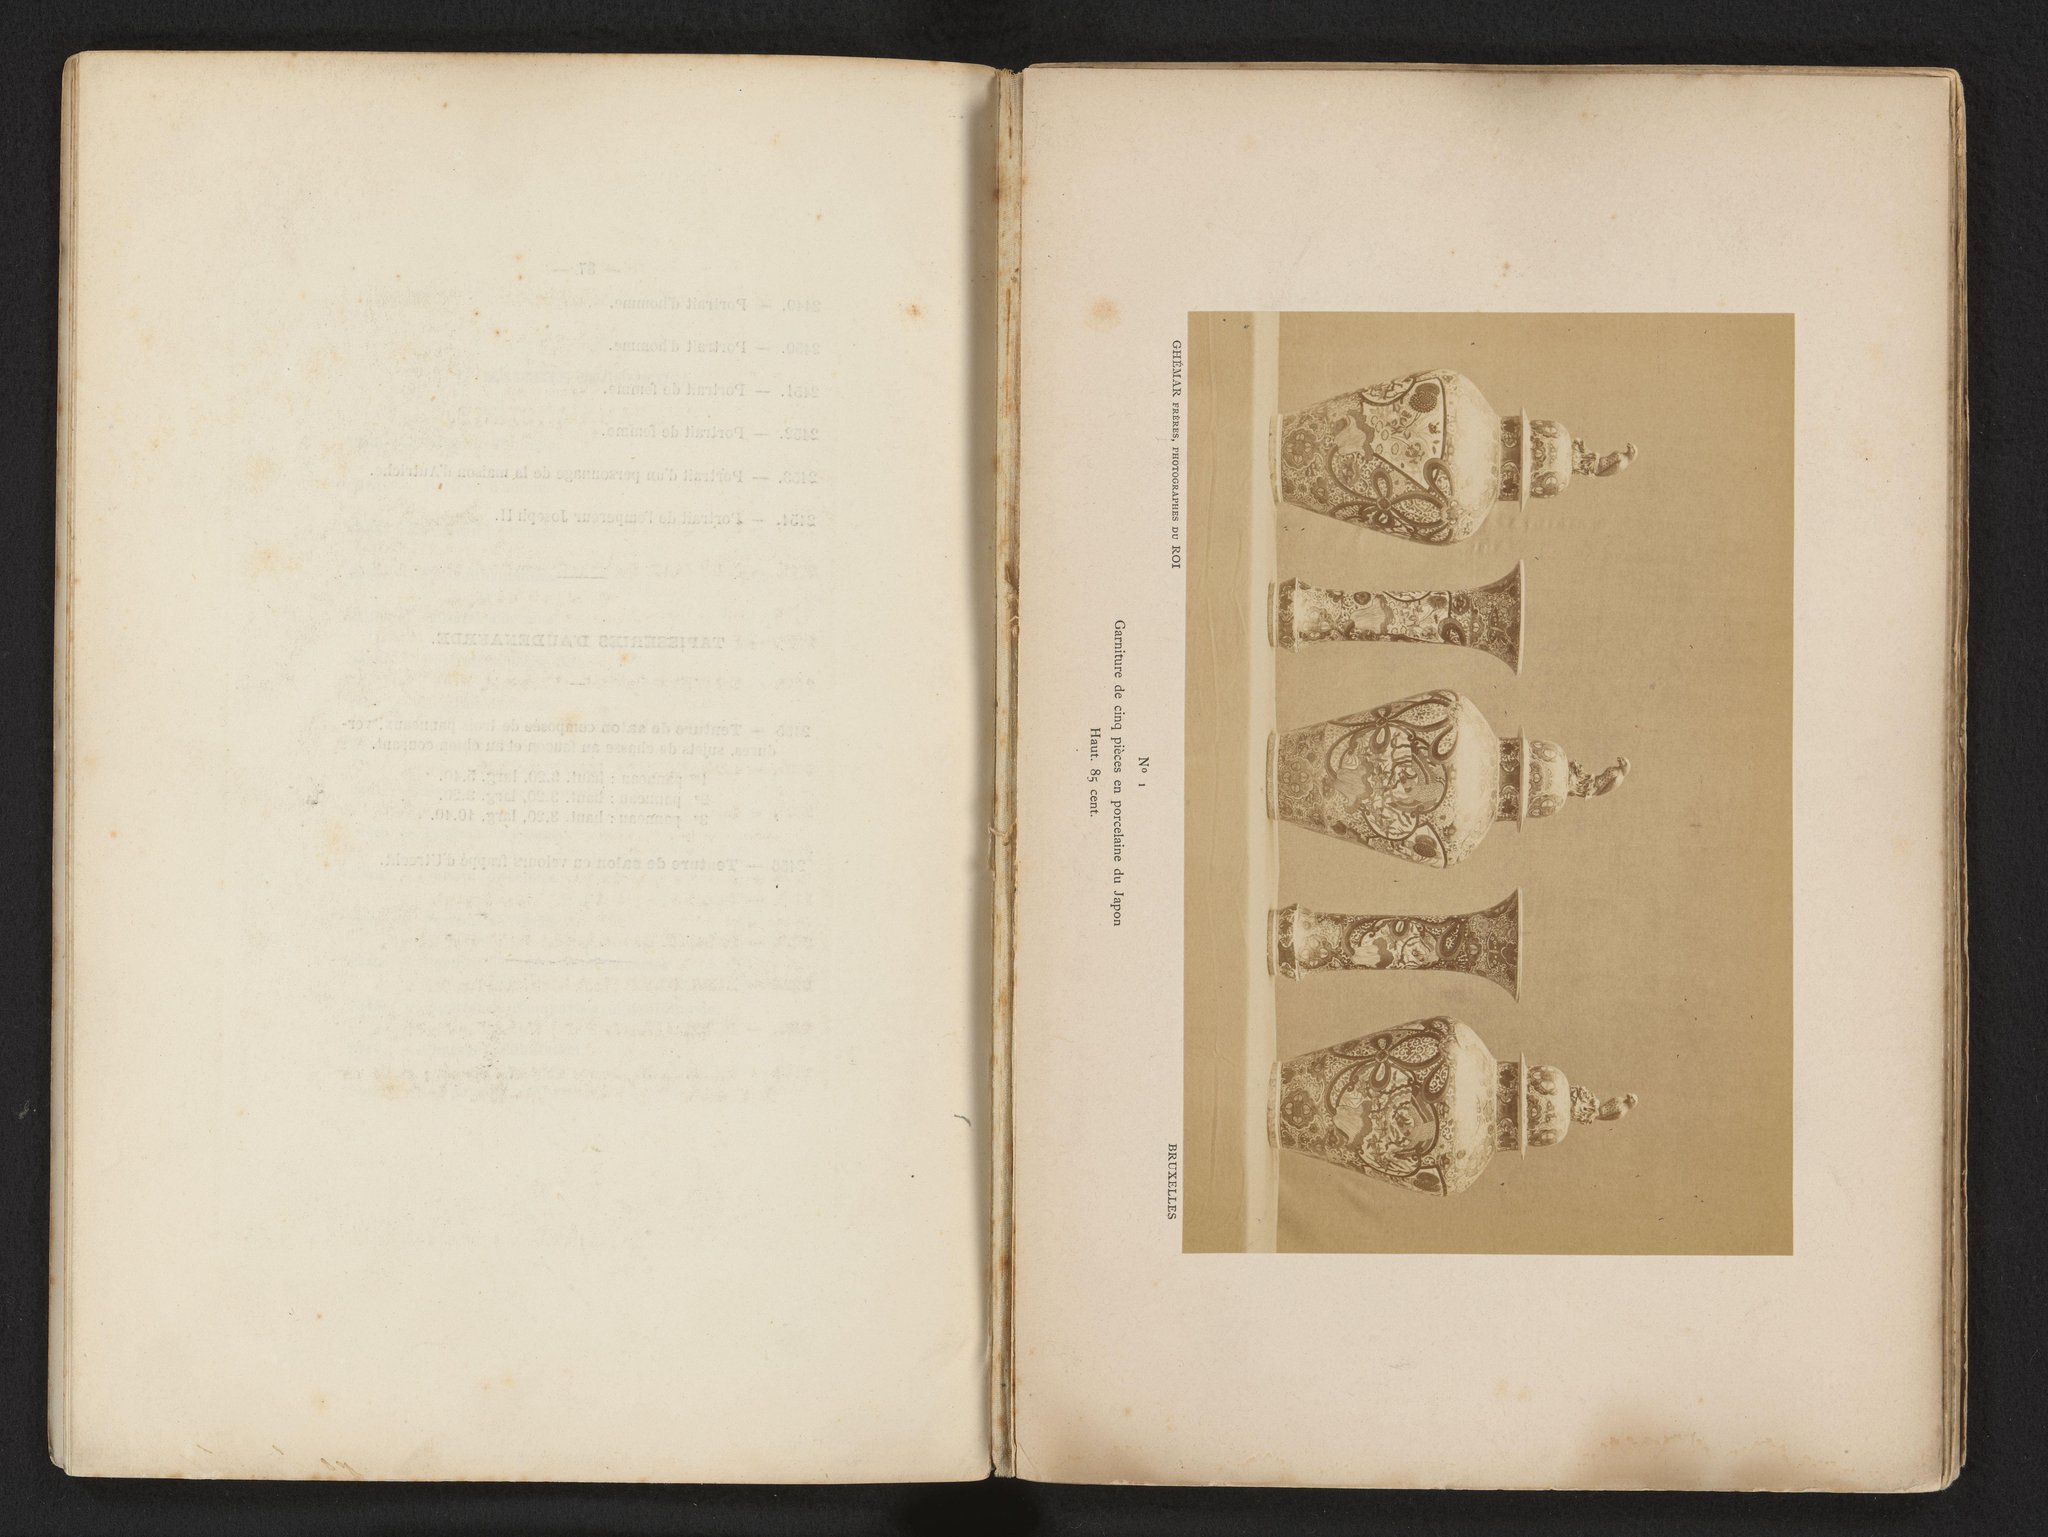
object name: page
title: Vijf Japanse vazen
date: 1870-1875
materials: photographic support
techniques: albumen print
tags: container of ceramics: jar, jug, pot, vase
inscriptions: inscription: ‘No.1 Garniture de cinq pièces en porcelaine du japon Haut. 85 cent’